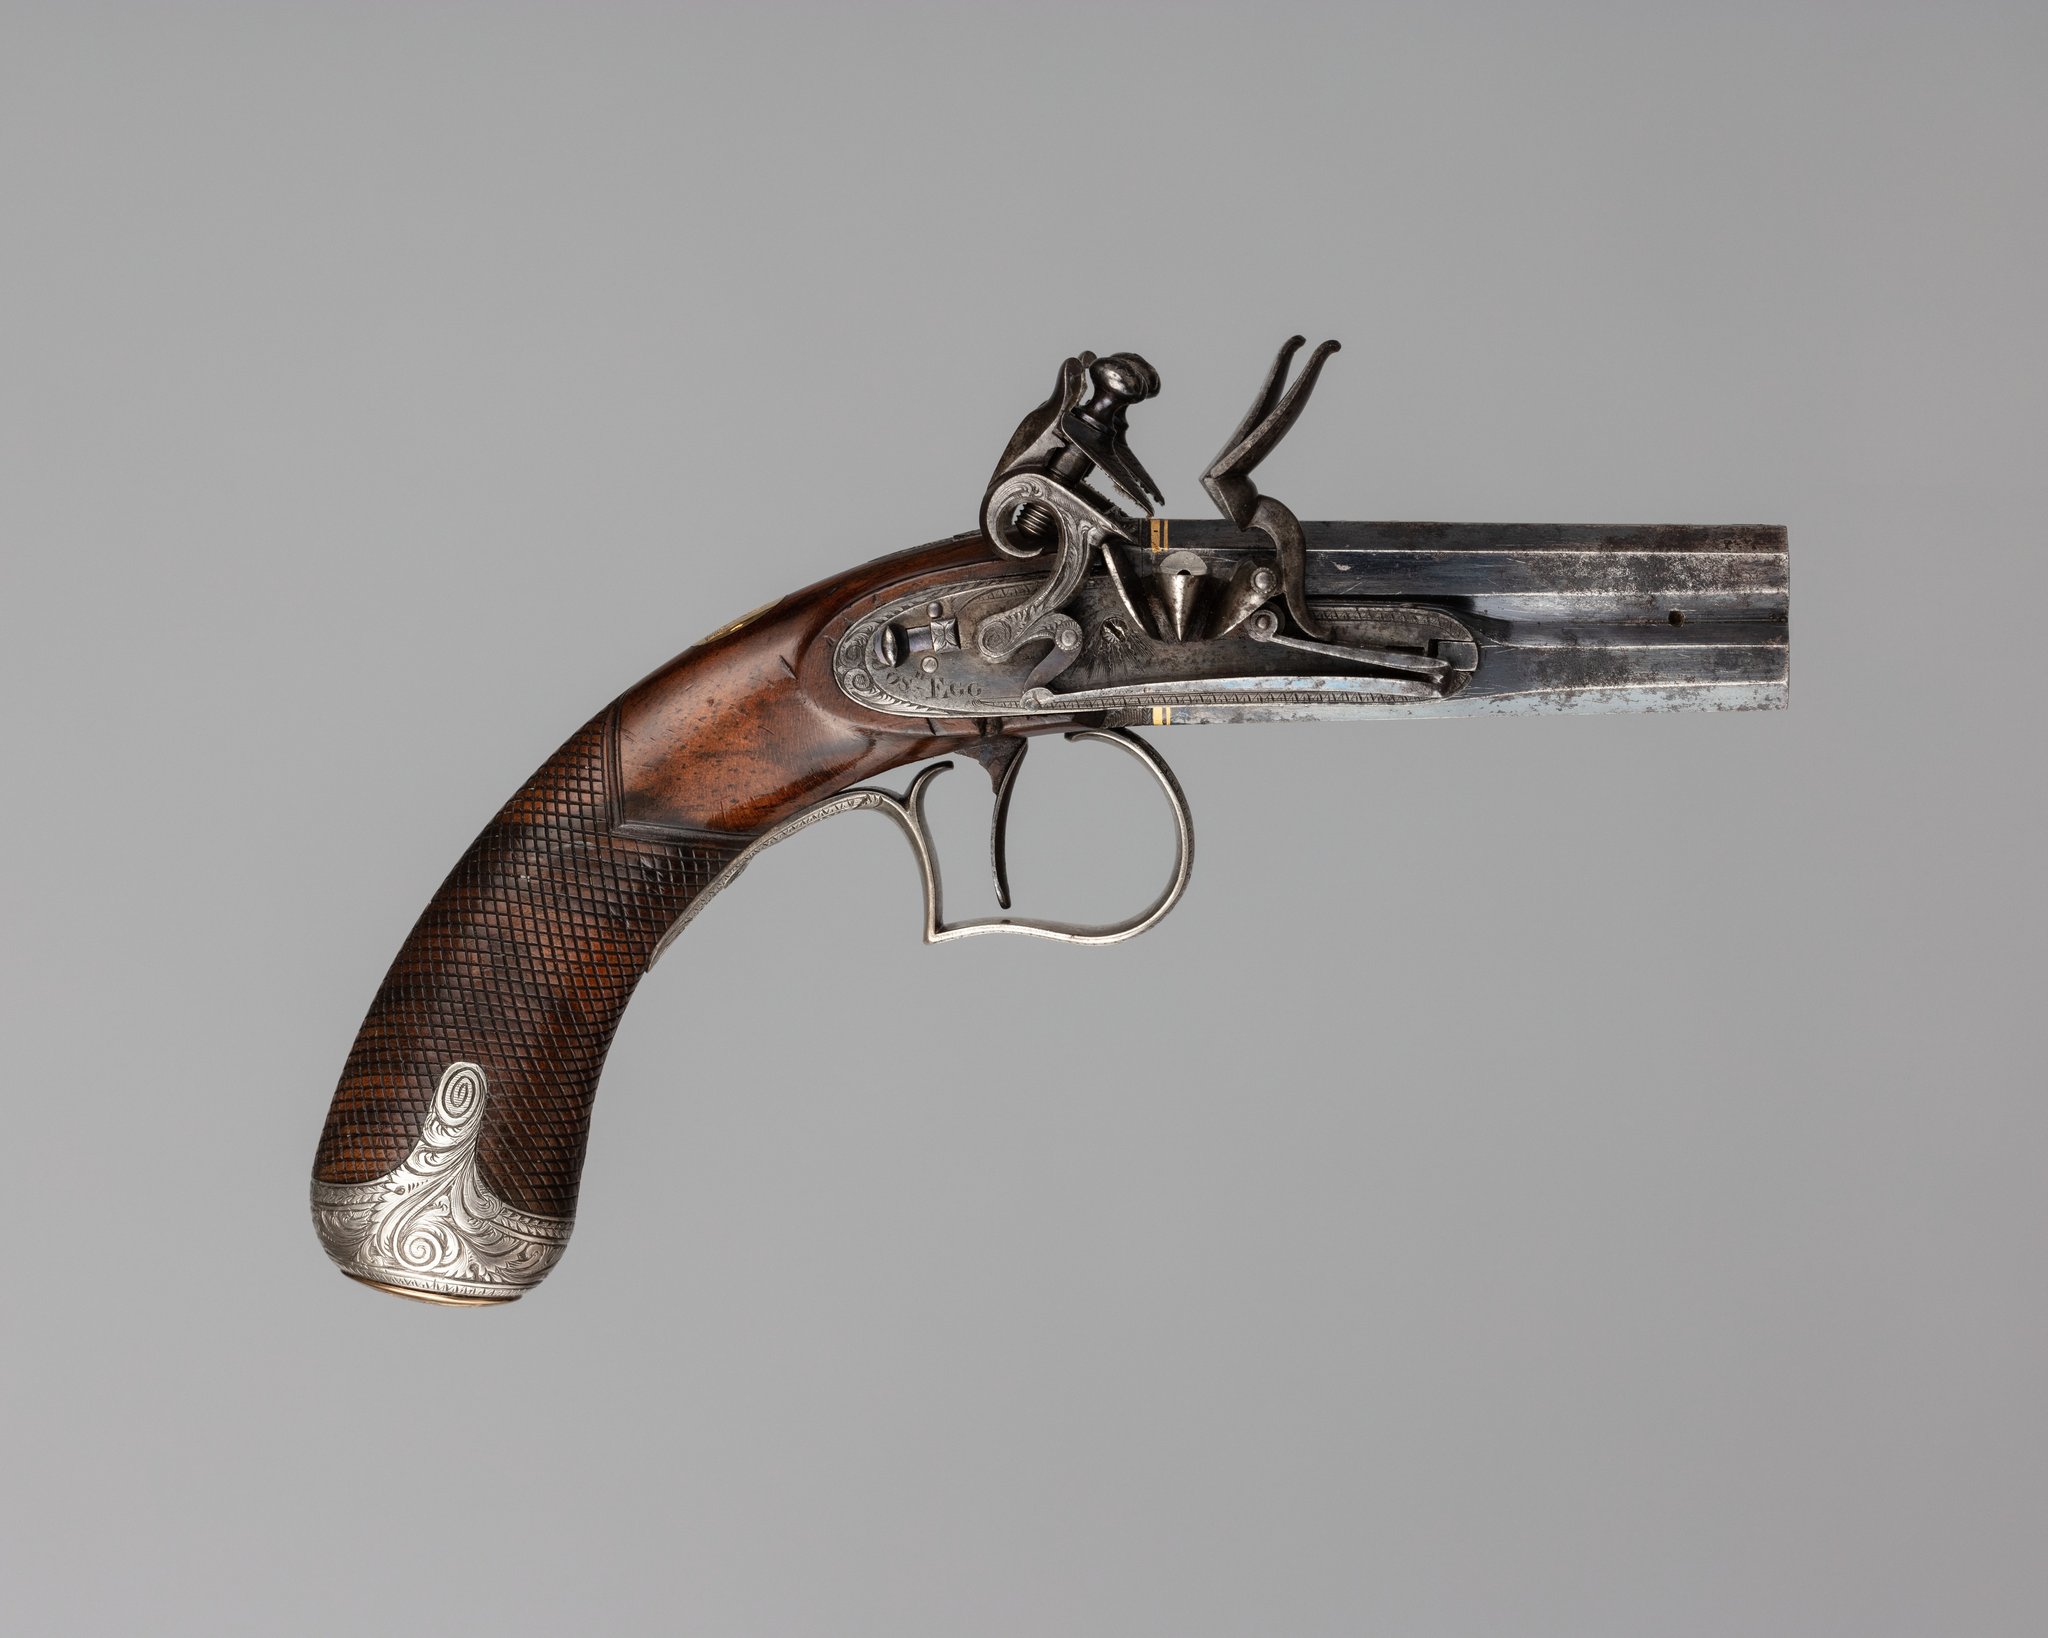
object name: over and under flintlock pistol with case and accessory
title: Over-and-Under Flintlock Pocket Pistol of the Hughes of Gwerclas Family with Case and Accessories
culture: british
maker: joseph egg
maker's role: gunsmith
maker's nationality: british, born france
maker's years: 1775-1837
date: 1815-1820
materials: brass, bronze, gold, leather, paper, platinum, silver, steel, textile, wood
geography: england